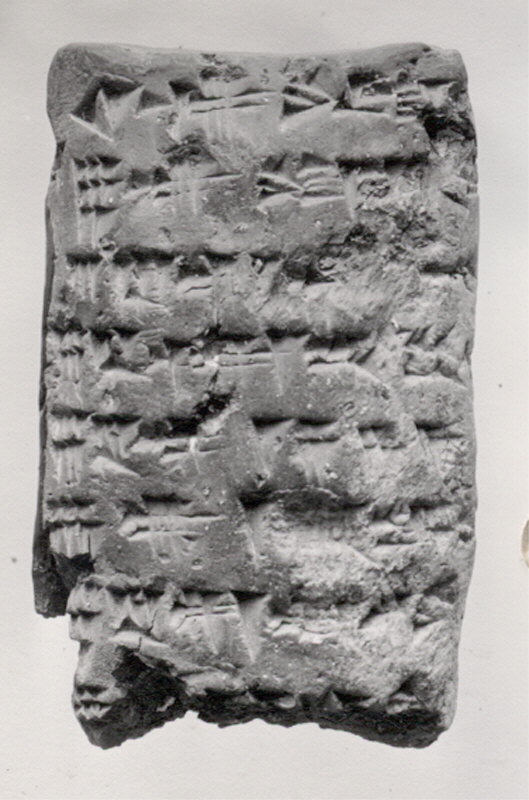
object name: cuneiform tablet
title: Cuneiform tablet: account of work obligations and halilu-tool allocations, Ebabbar archive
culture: babylonian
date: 626-539 BCE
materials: clay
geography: mesopotamia